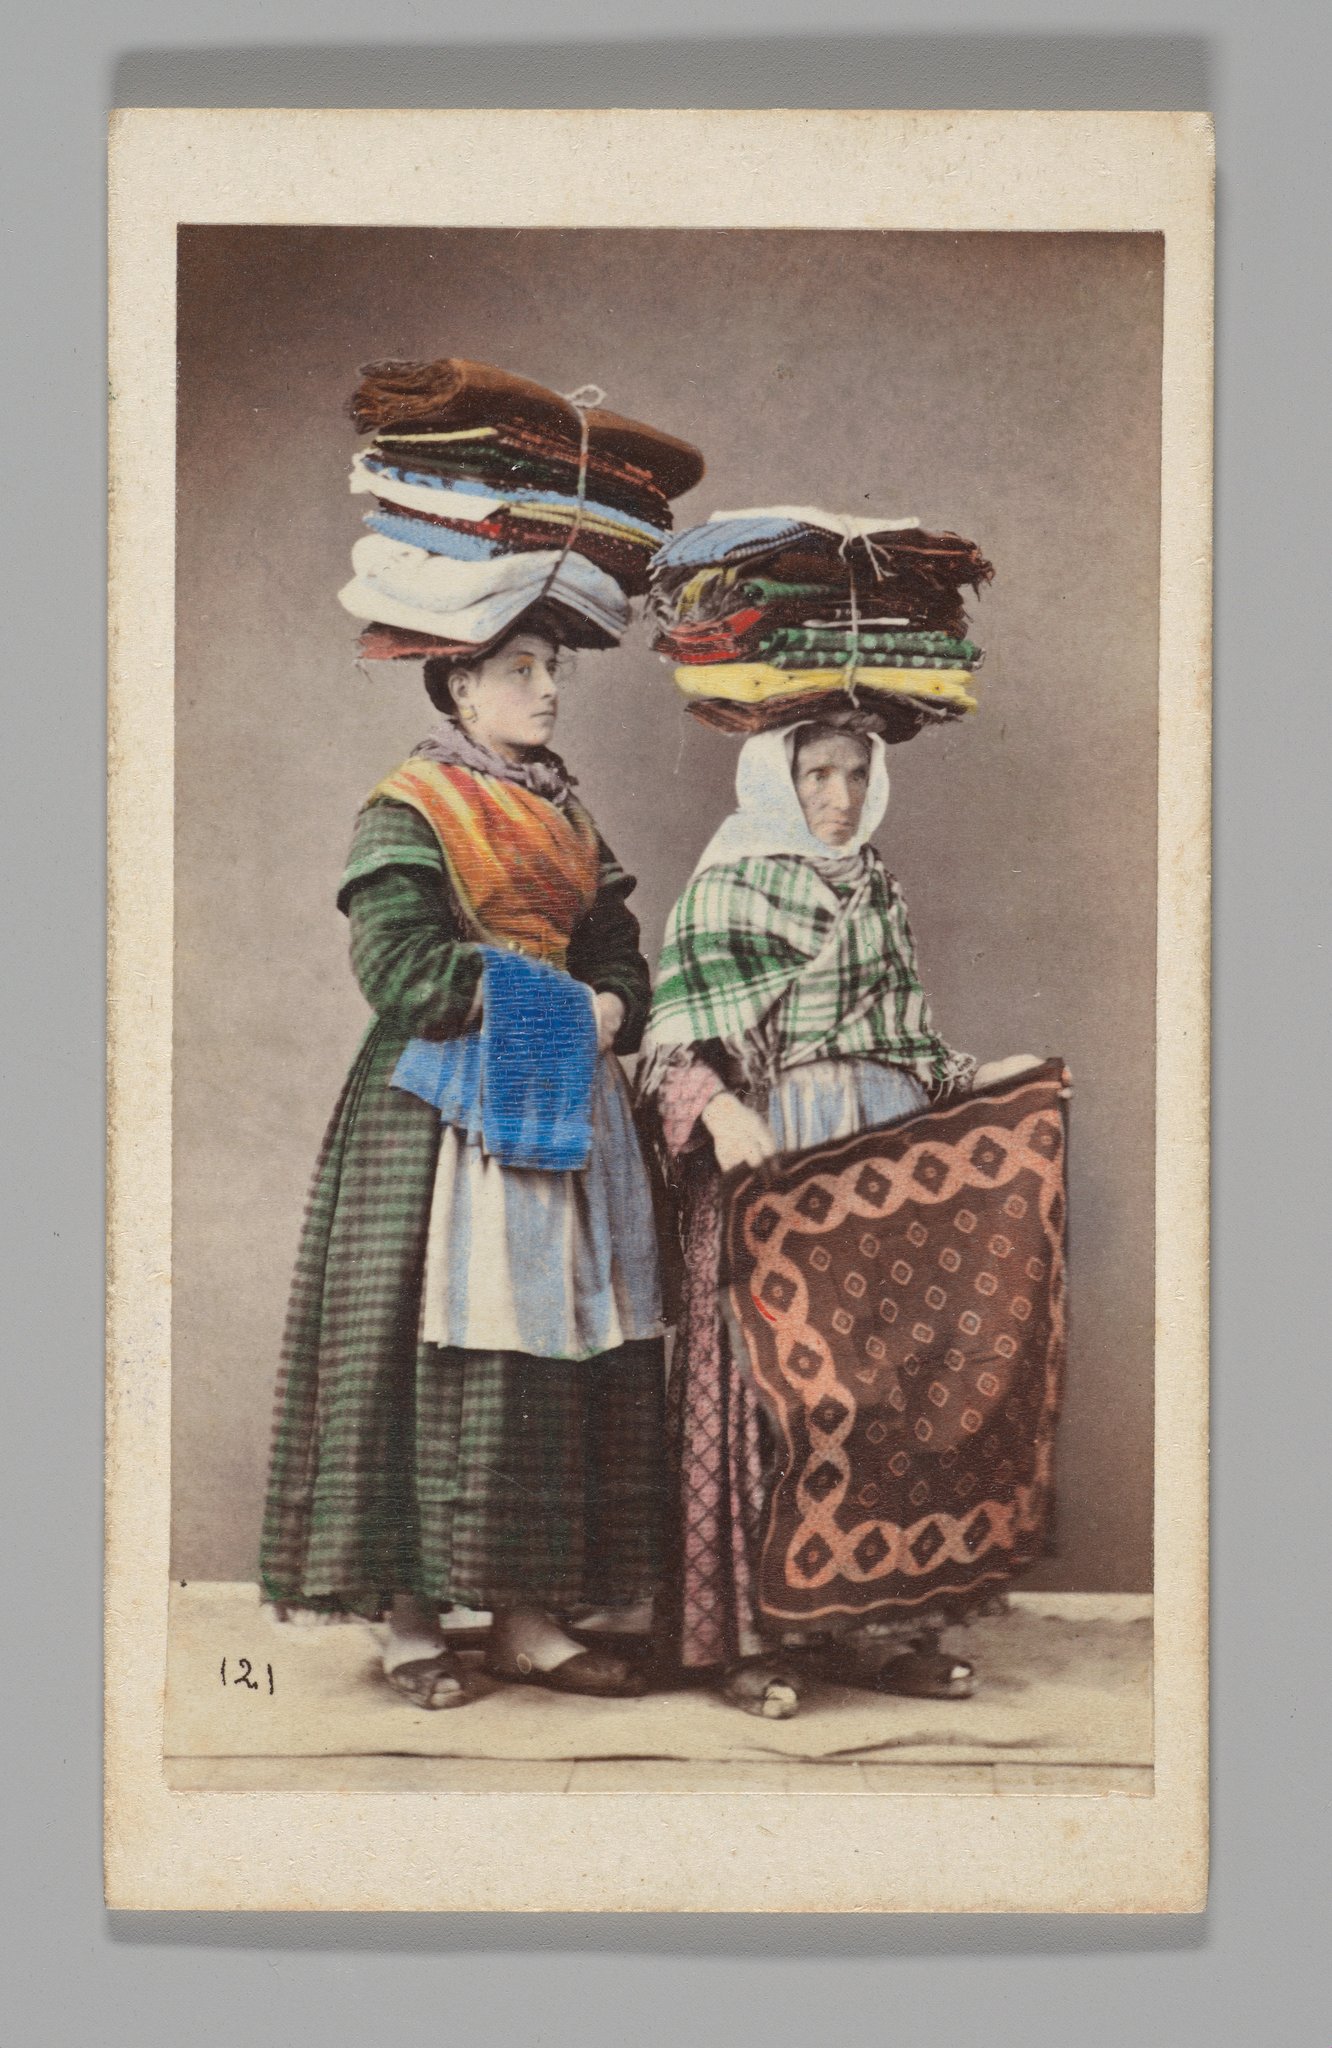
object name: carte de visite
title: [Studio Portrait: Two Laundresses, Naples]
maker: giorgio conrad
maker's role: fotograaf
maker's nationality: italian, born switzerland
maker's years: 1827-1889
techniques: albumen silver print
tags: portraits,women